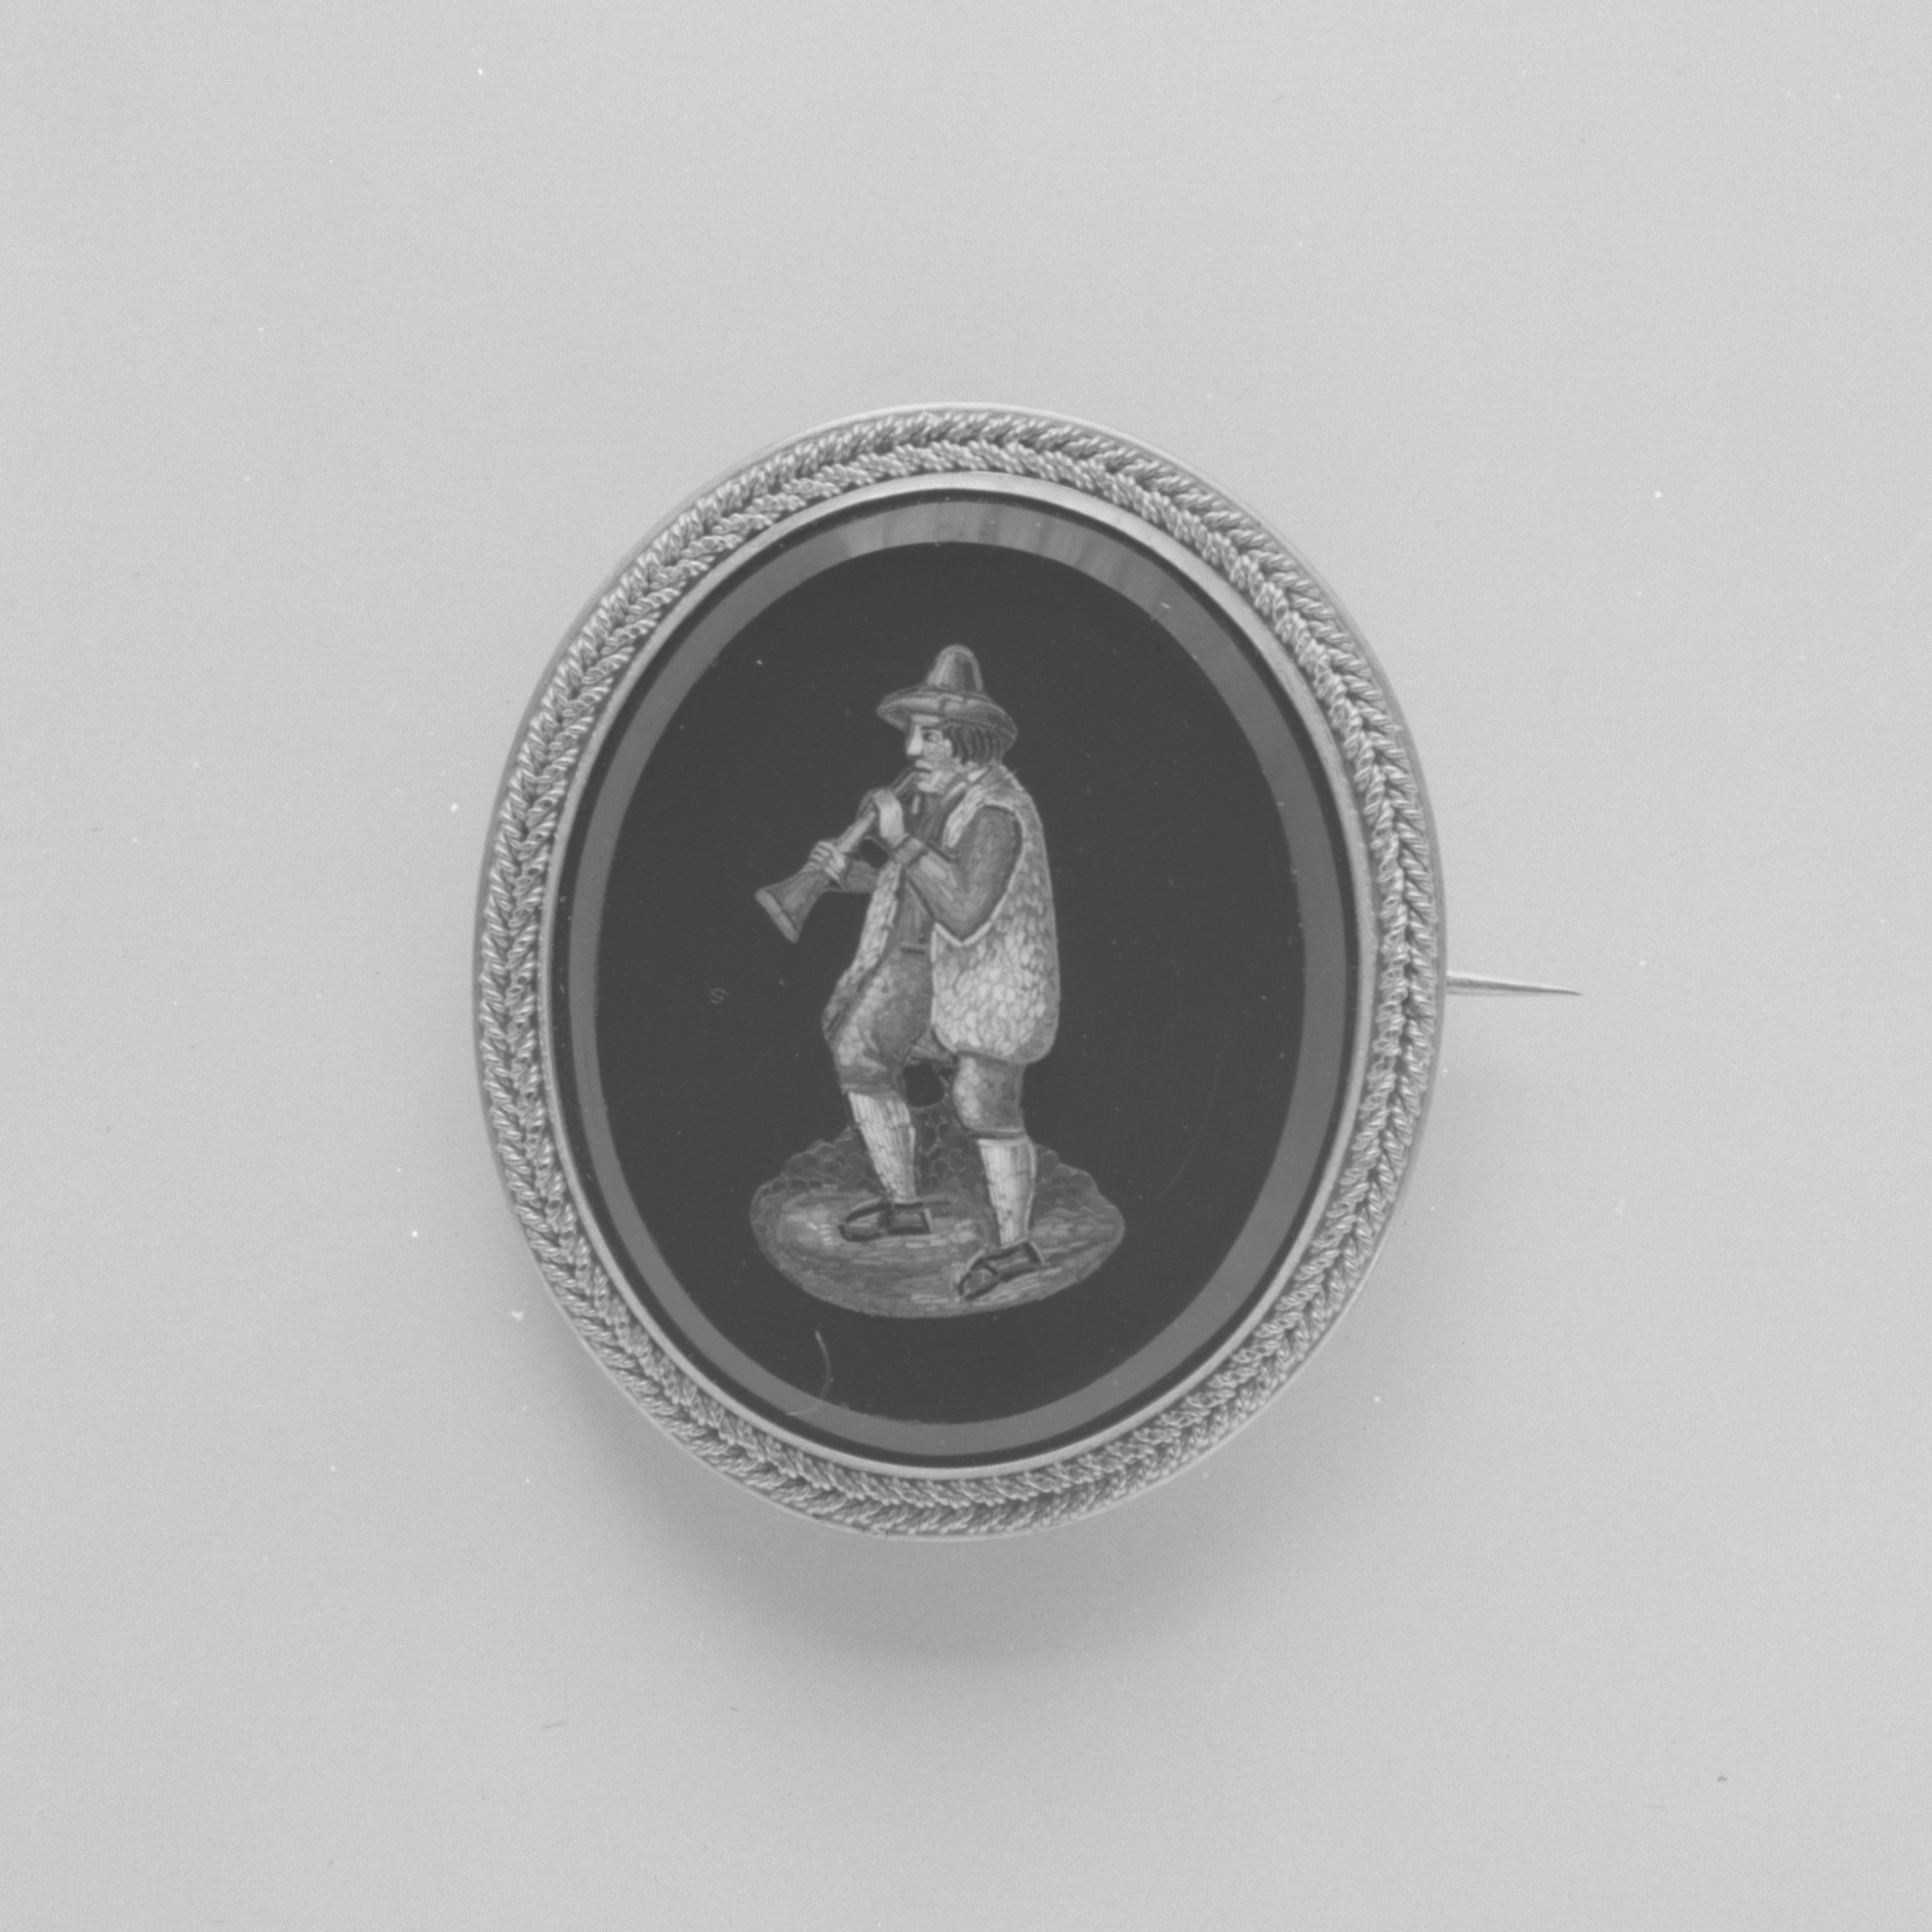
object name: brooch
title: Brooch (part of a set)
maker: g.l. barberi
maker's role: maker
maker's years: 1800-1900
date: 1801-1900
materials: glass, gold, onyx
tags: musical instruments,men